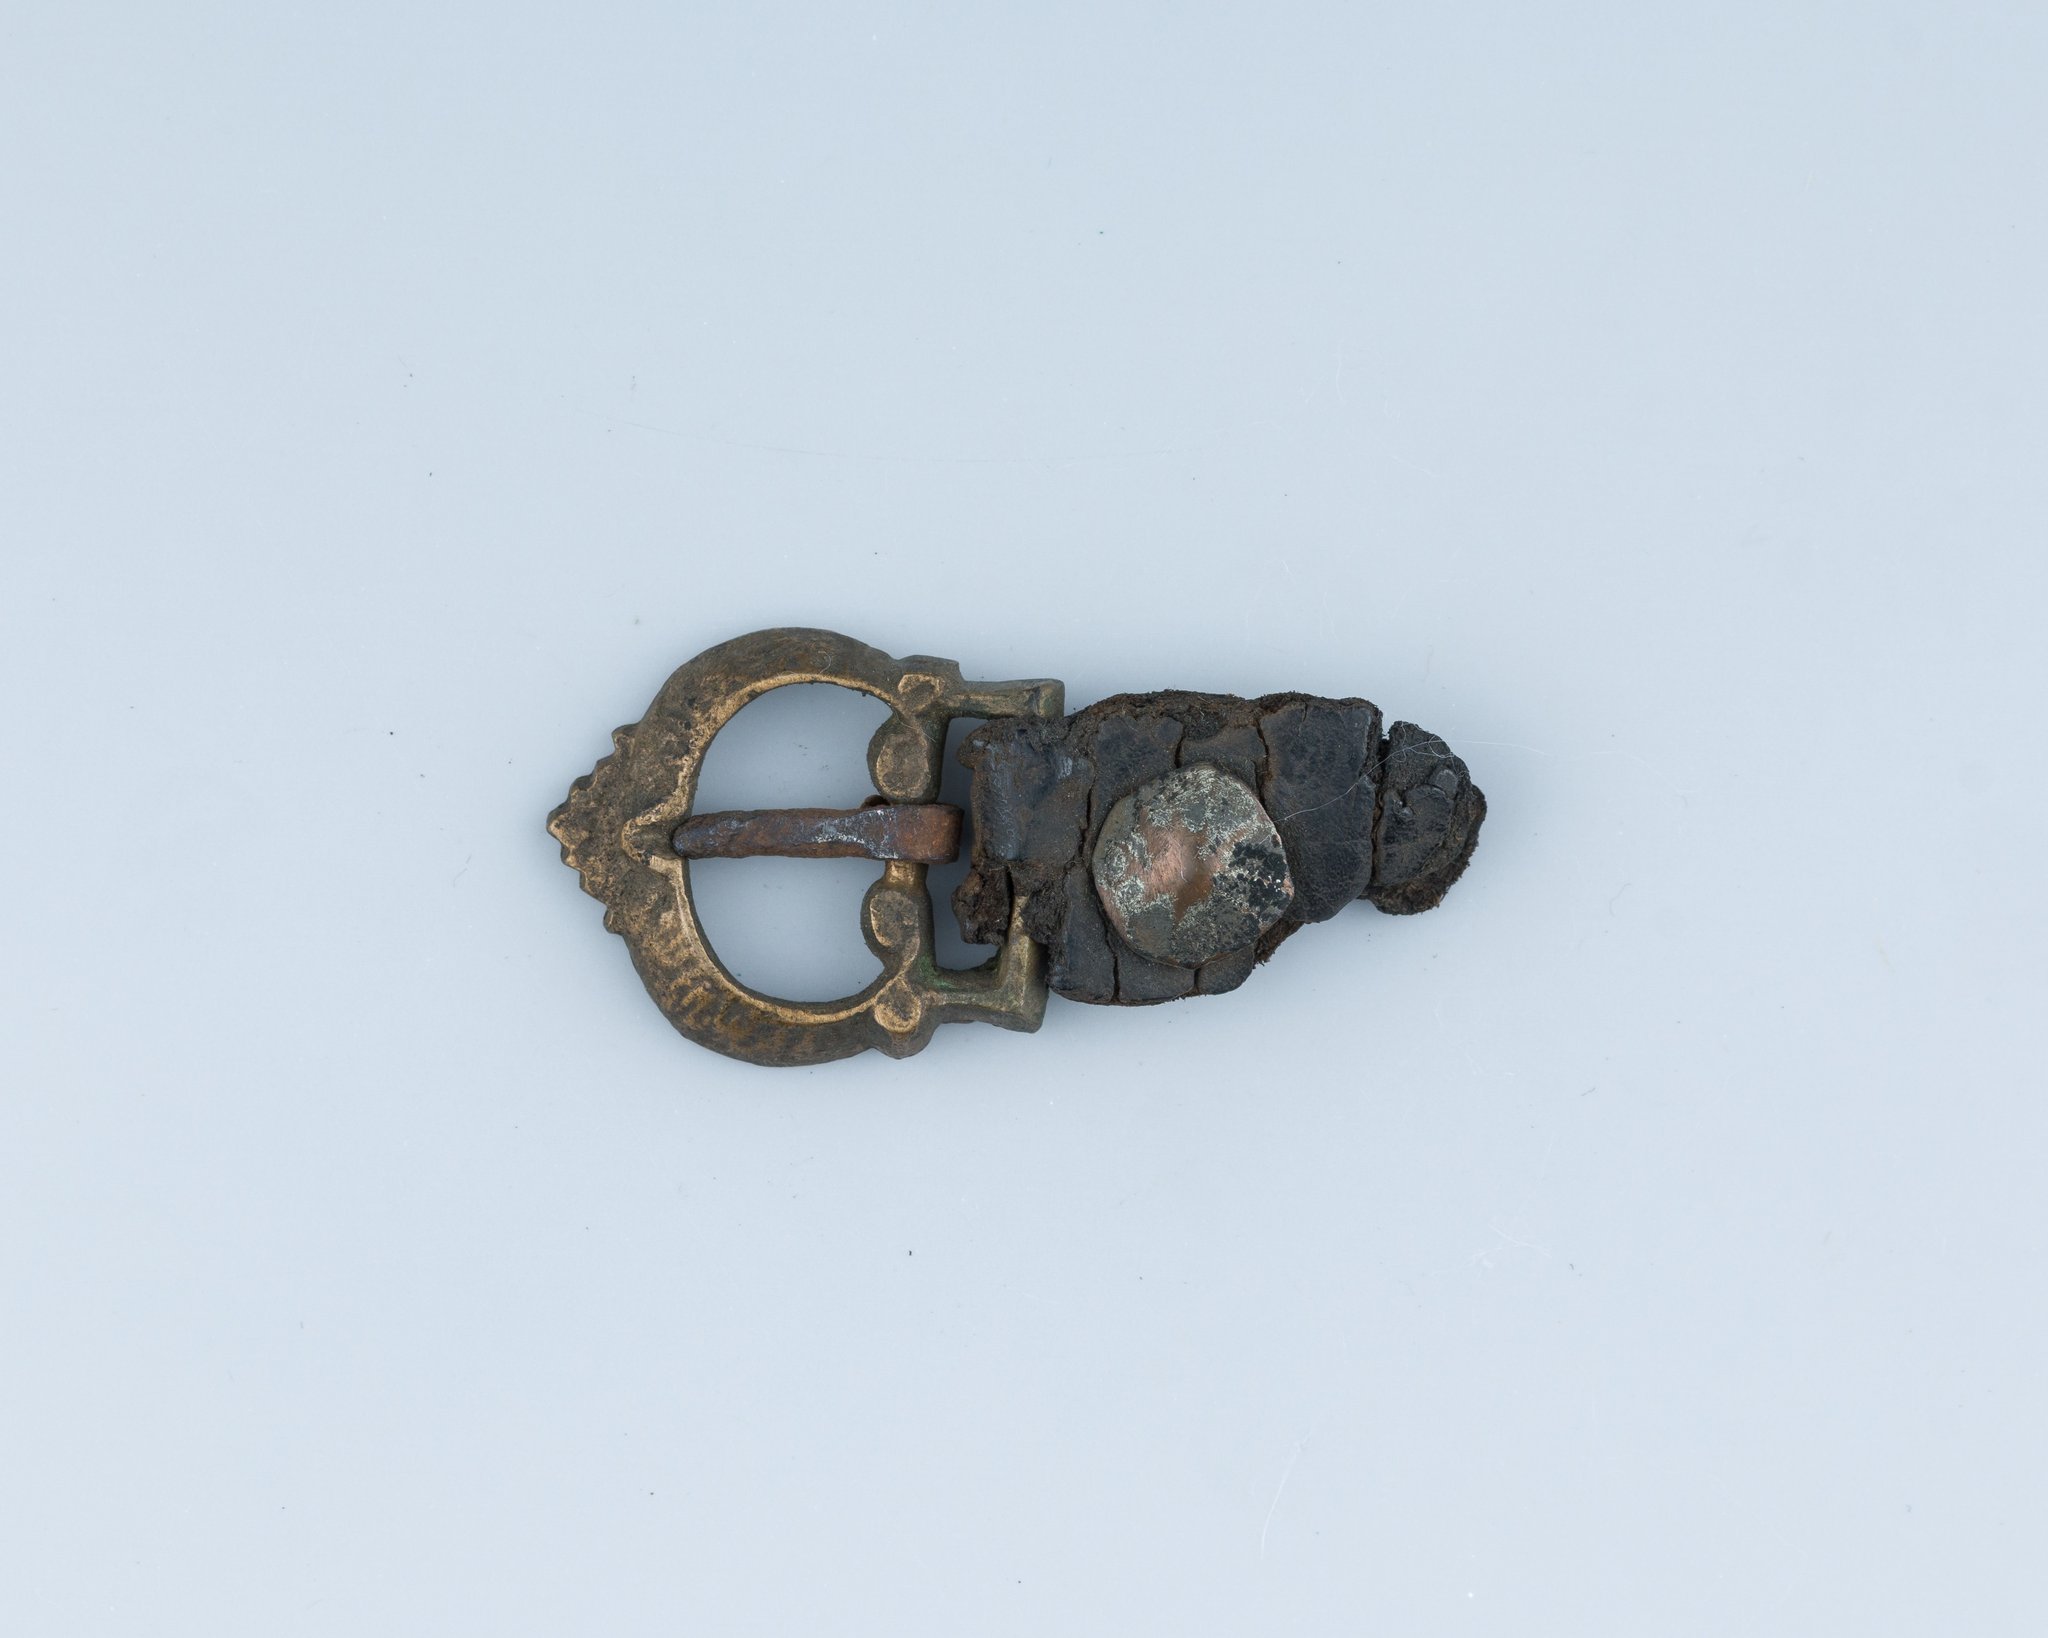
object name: buckle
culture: european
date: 1401-1700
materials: brass